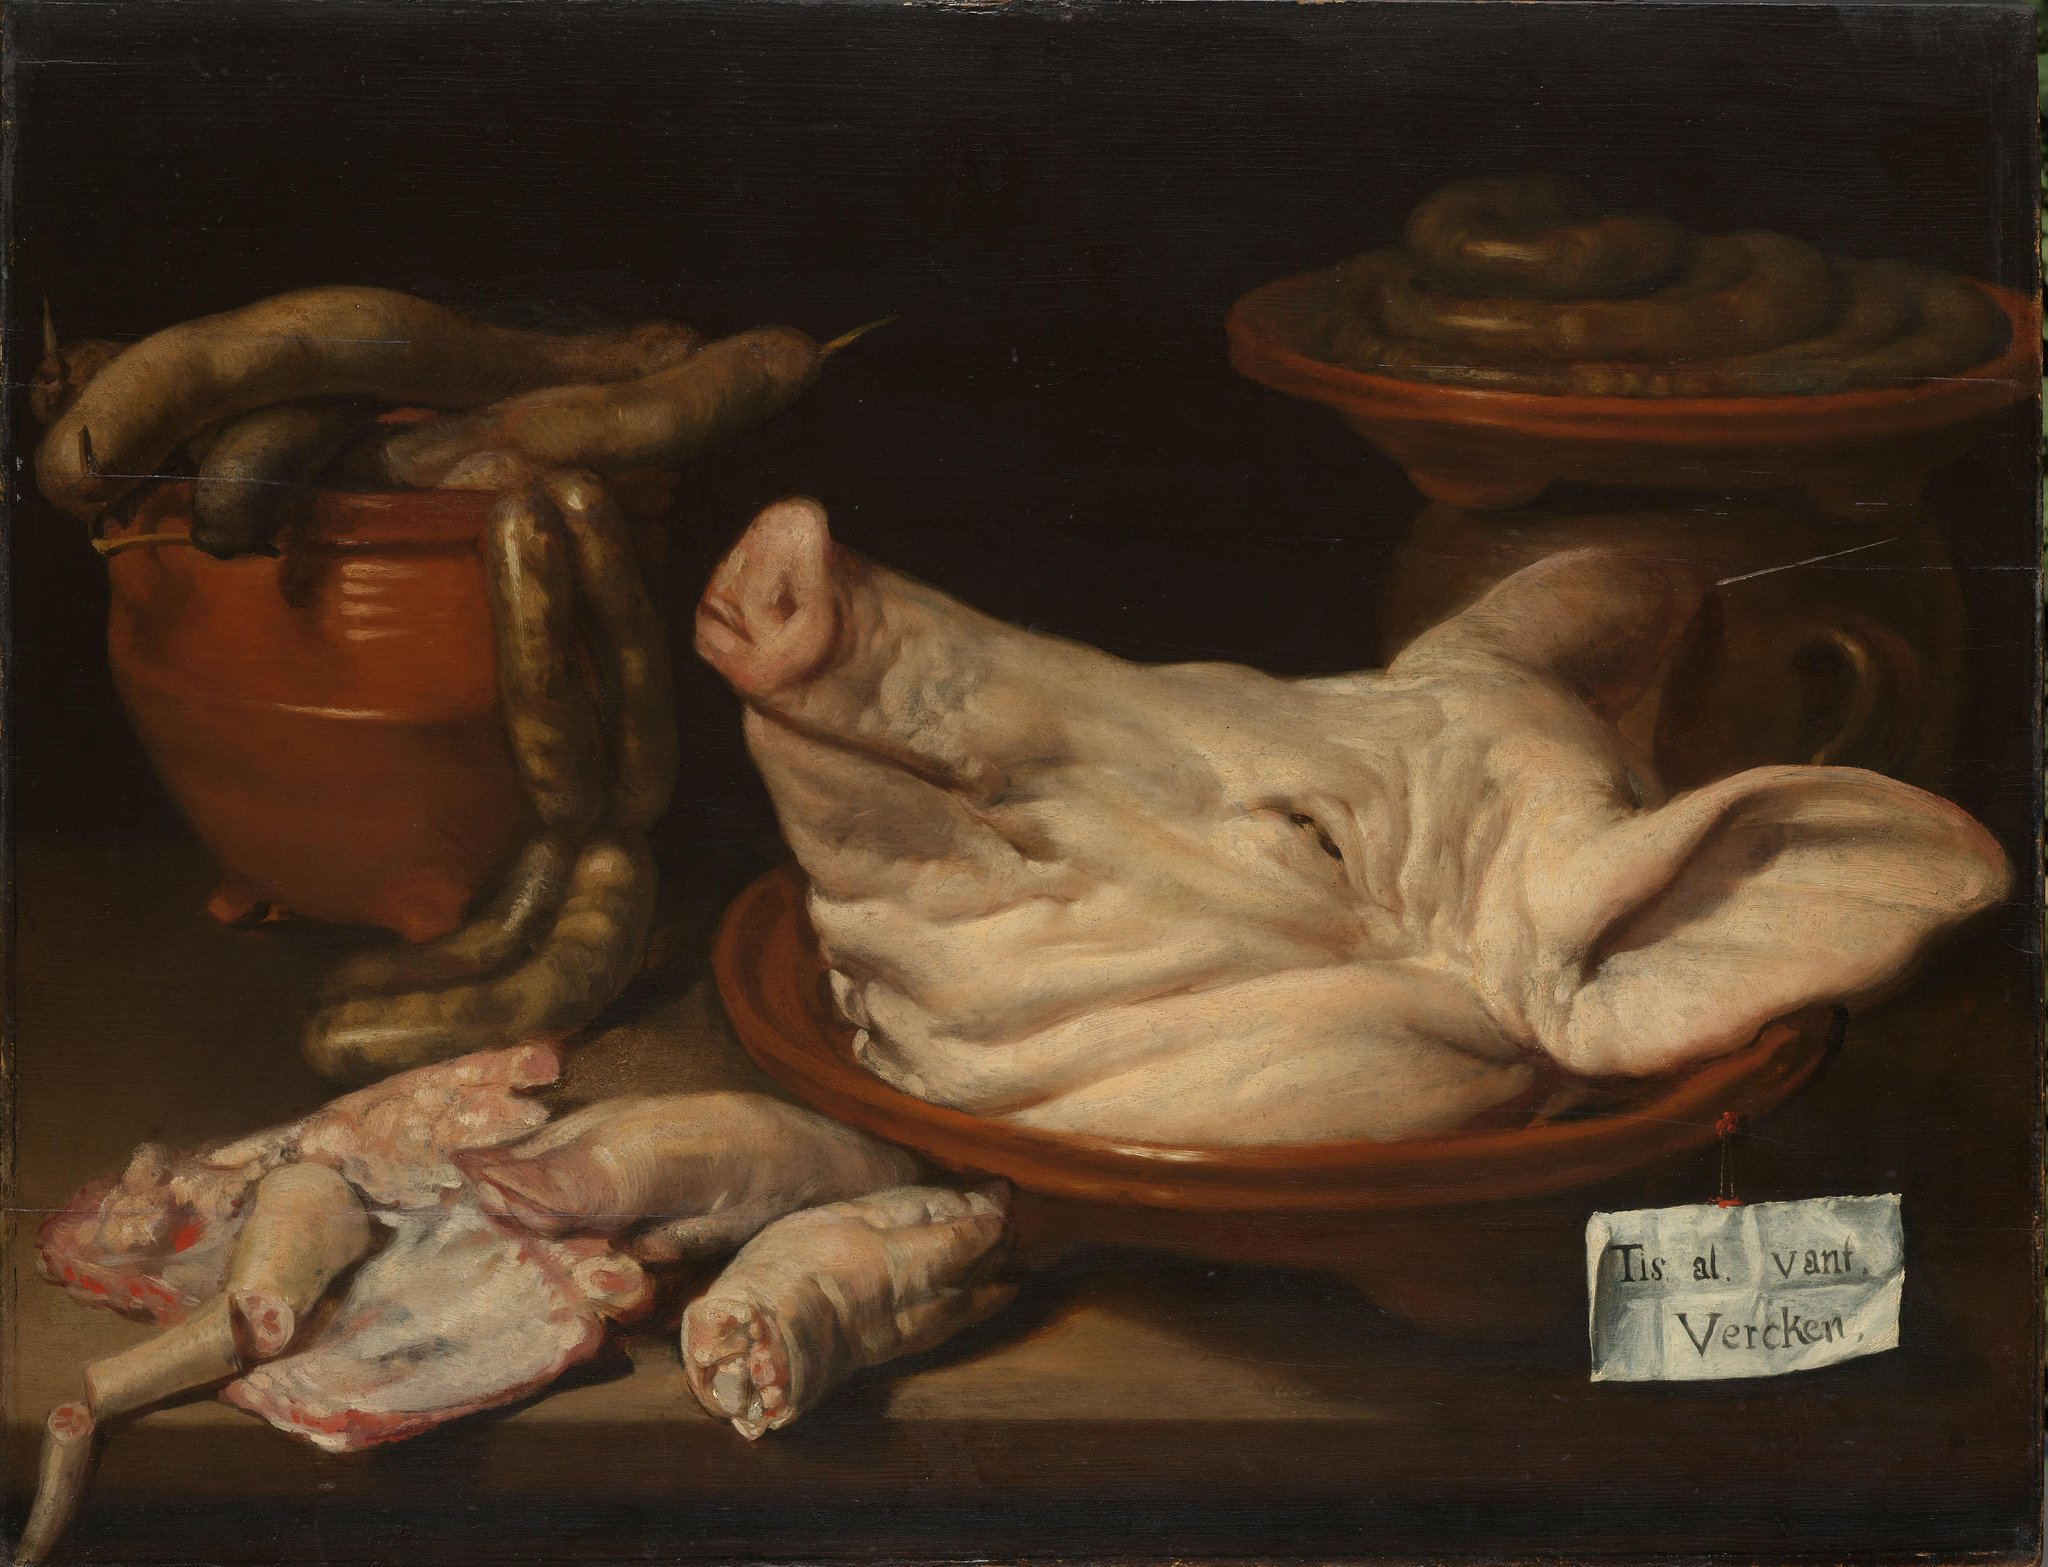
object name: painting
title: Still Life with Pig's Head, Pig's Knuckles and Sausage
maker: monogrammist jvr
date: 1600-1650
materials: oil, panel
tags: pig, still life of related objects, meat; still life of meat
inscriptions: monogram: ‘JVR F.’, inscription: ‘Tis al vant / Vercken’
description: Stilleven met een varkenskop op een aardewerken bord, enkele varkenspootjes en verschillende strengen worst op een bord en in een pot.